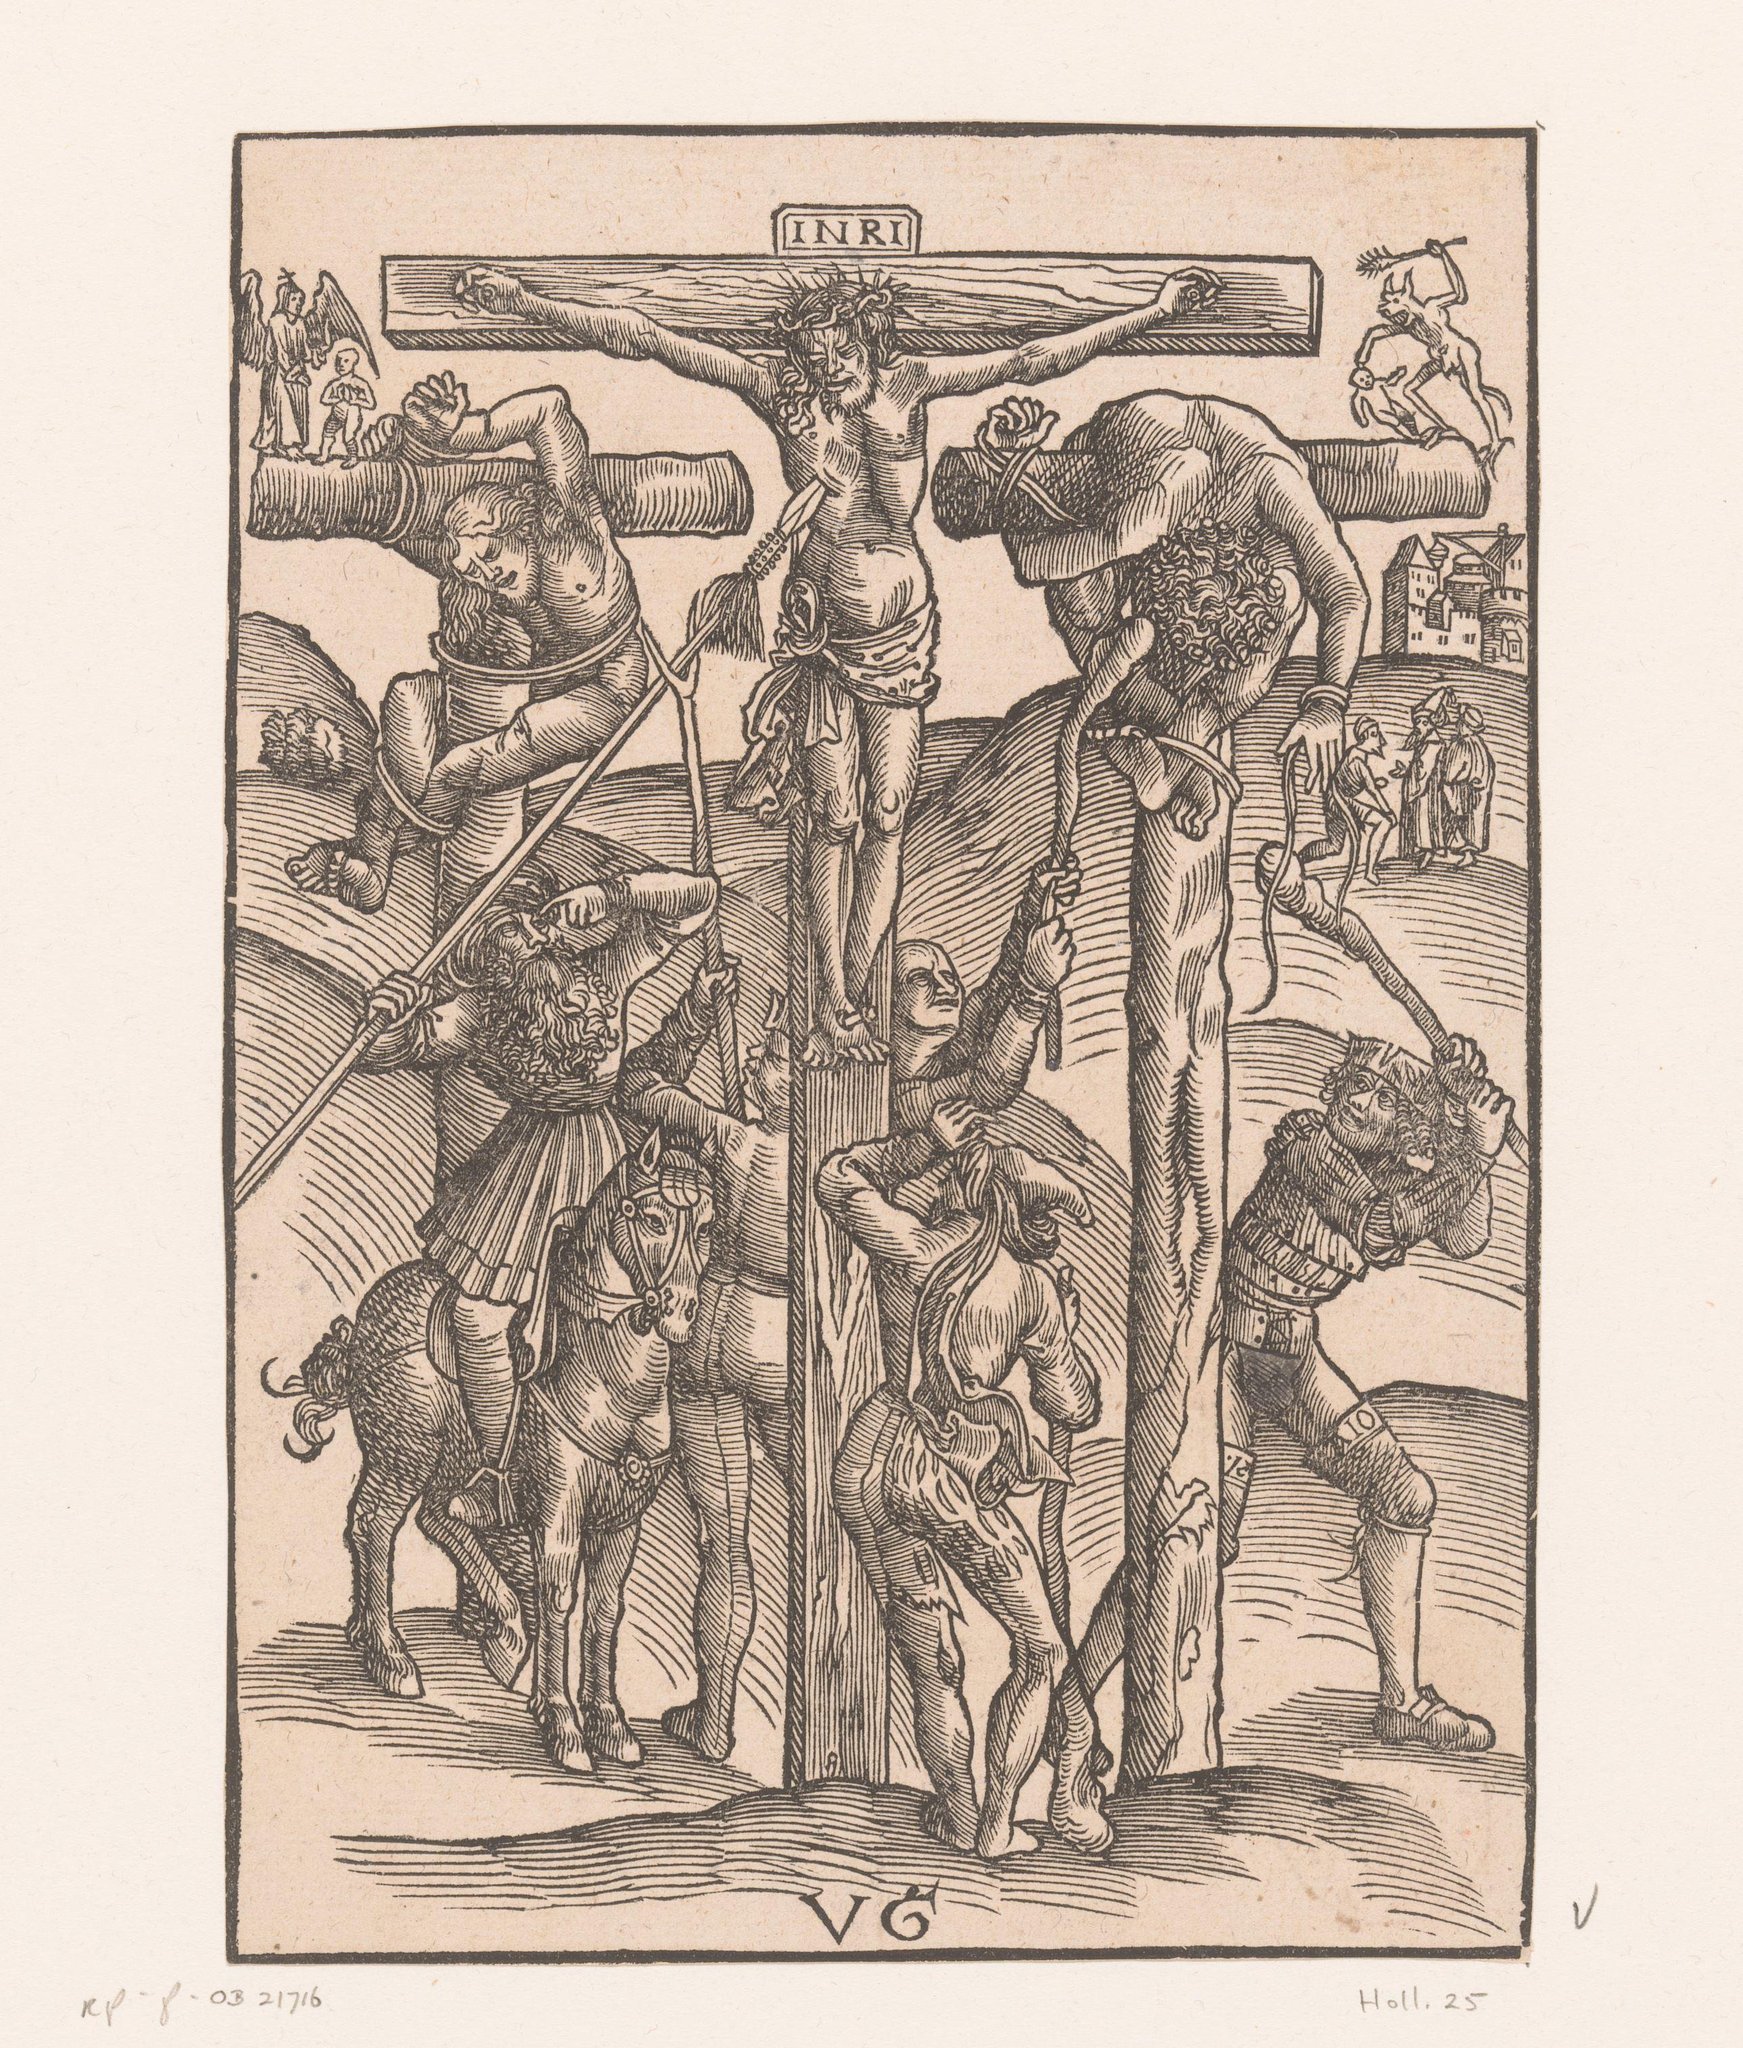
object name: book illustration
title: Passie van Christus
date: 1506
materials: paper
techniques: woodcut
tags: longinus pierces christ's side with a lance, the soldiers breaking the limbs of the malefactors with clubs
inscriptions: collector's mark: Lugt 240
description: Afkomstig uit: Der Text des Passions oder Lidens Christi (...). Straatsburg: N. Ringmann, 1506.